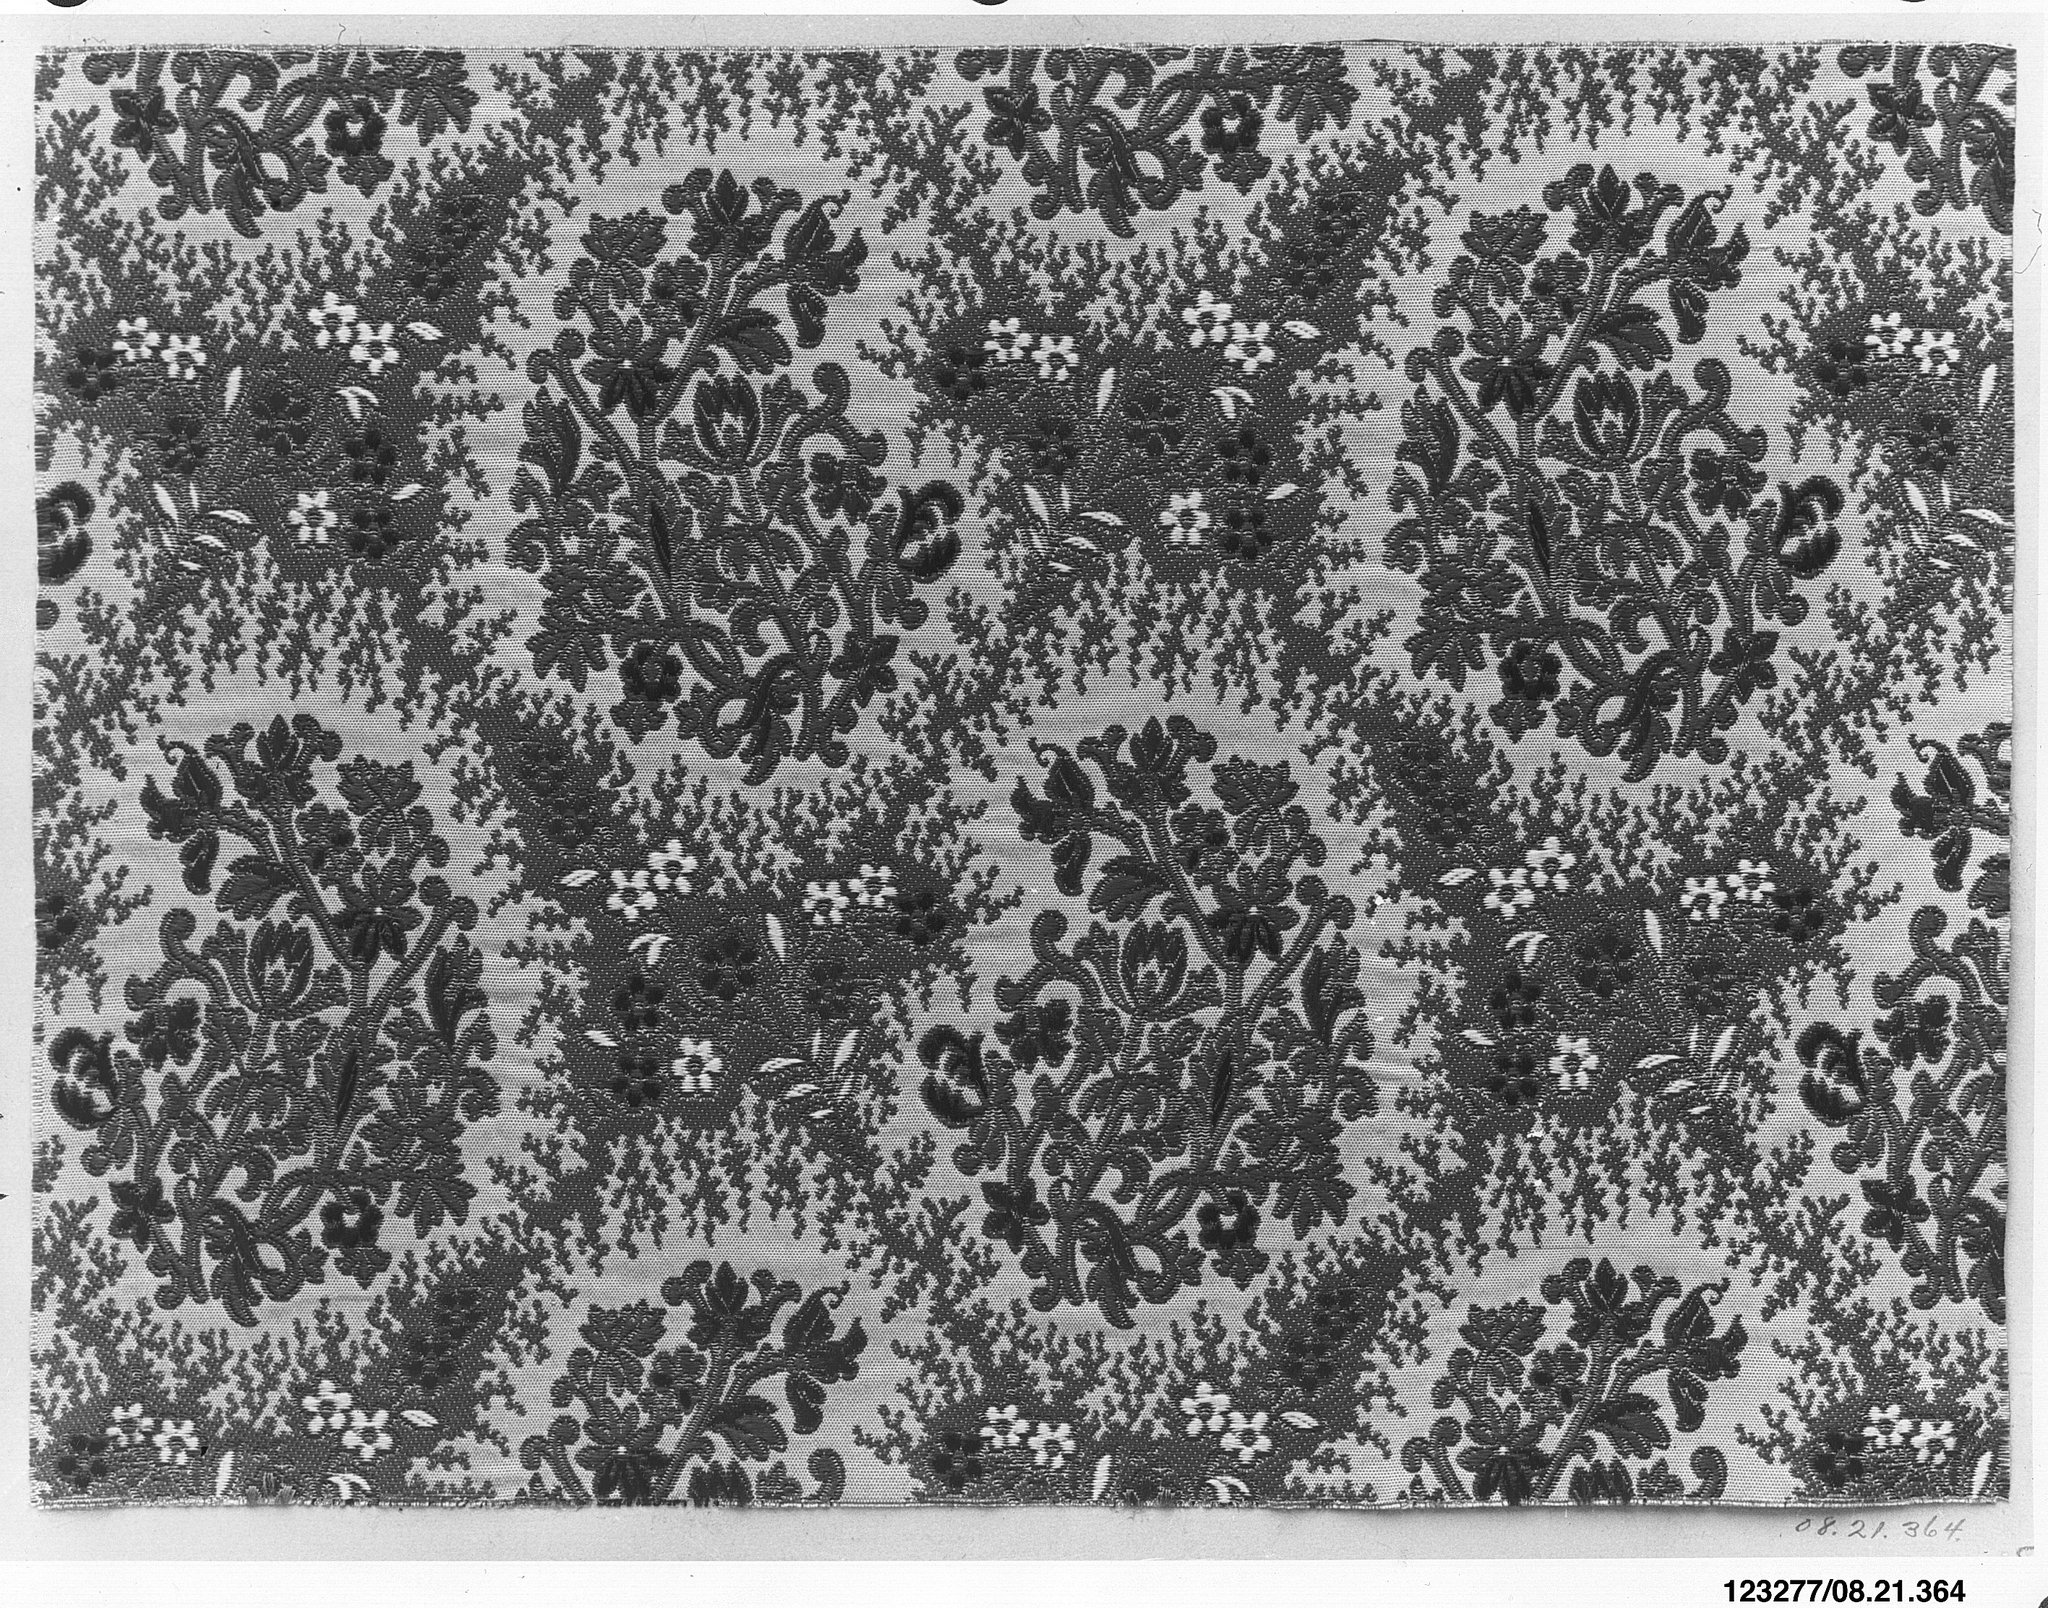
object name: textile sample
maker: Anonymous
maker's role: designer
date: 1900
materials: silk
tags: flowers